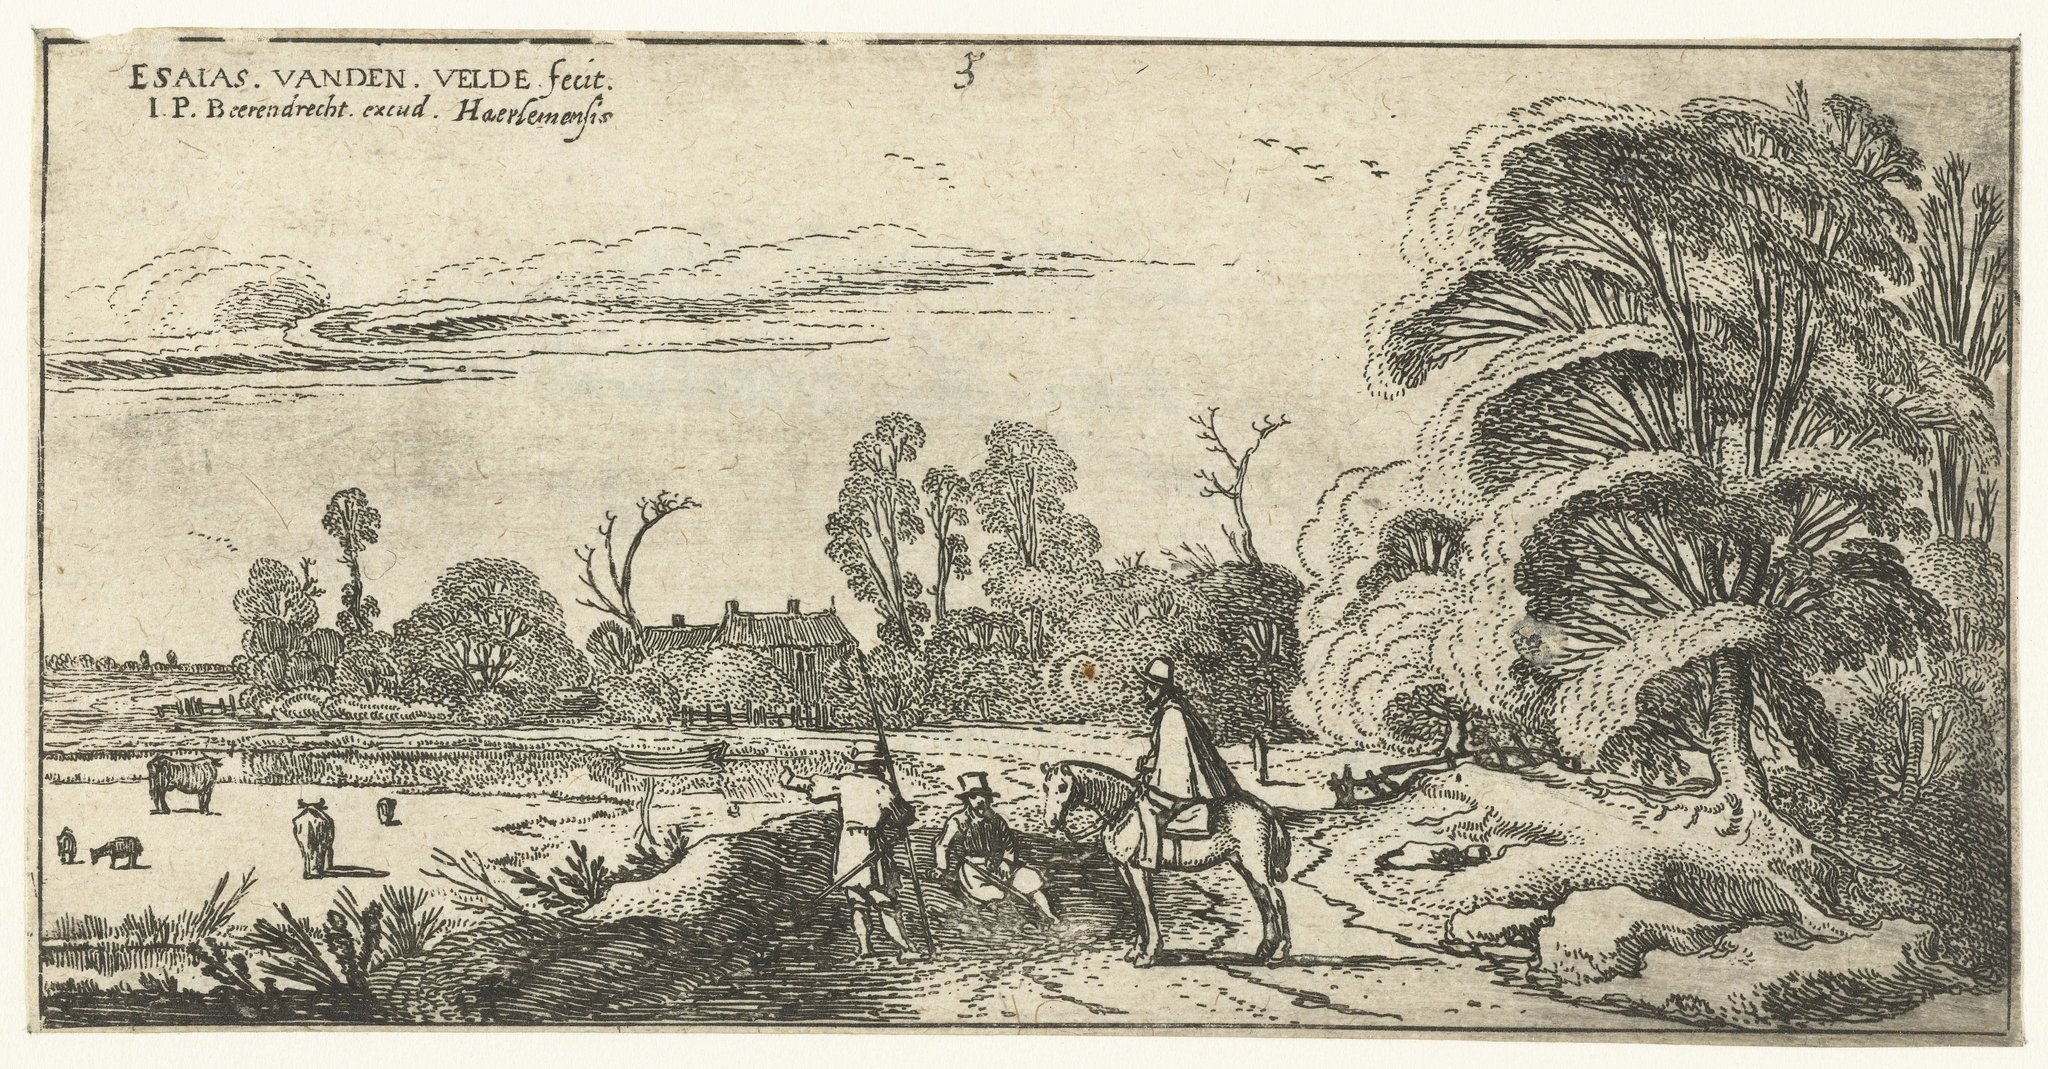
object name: print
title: Ruiter en wandelaars op een weg bij Lisse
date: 1615-1616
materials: paper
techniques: engraving, etching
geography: haarlem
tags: prospect of village, silhouette of village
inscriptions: collector's mark: Lugt 2228a